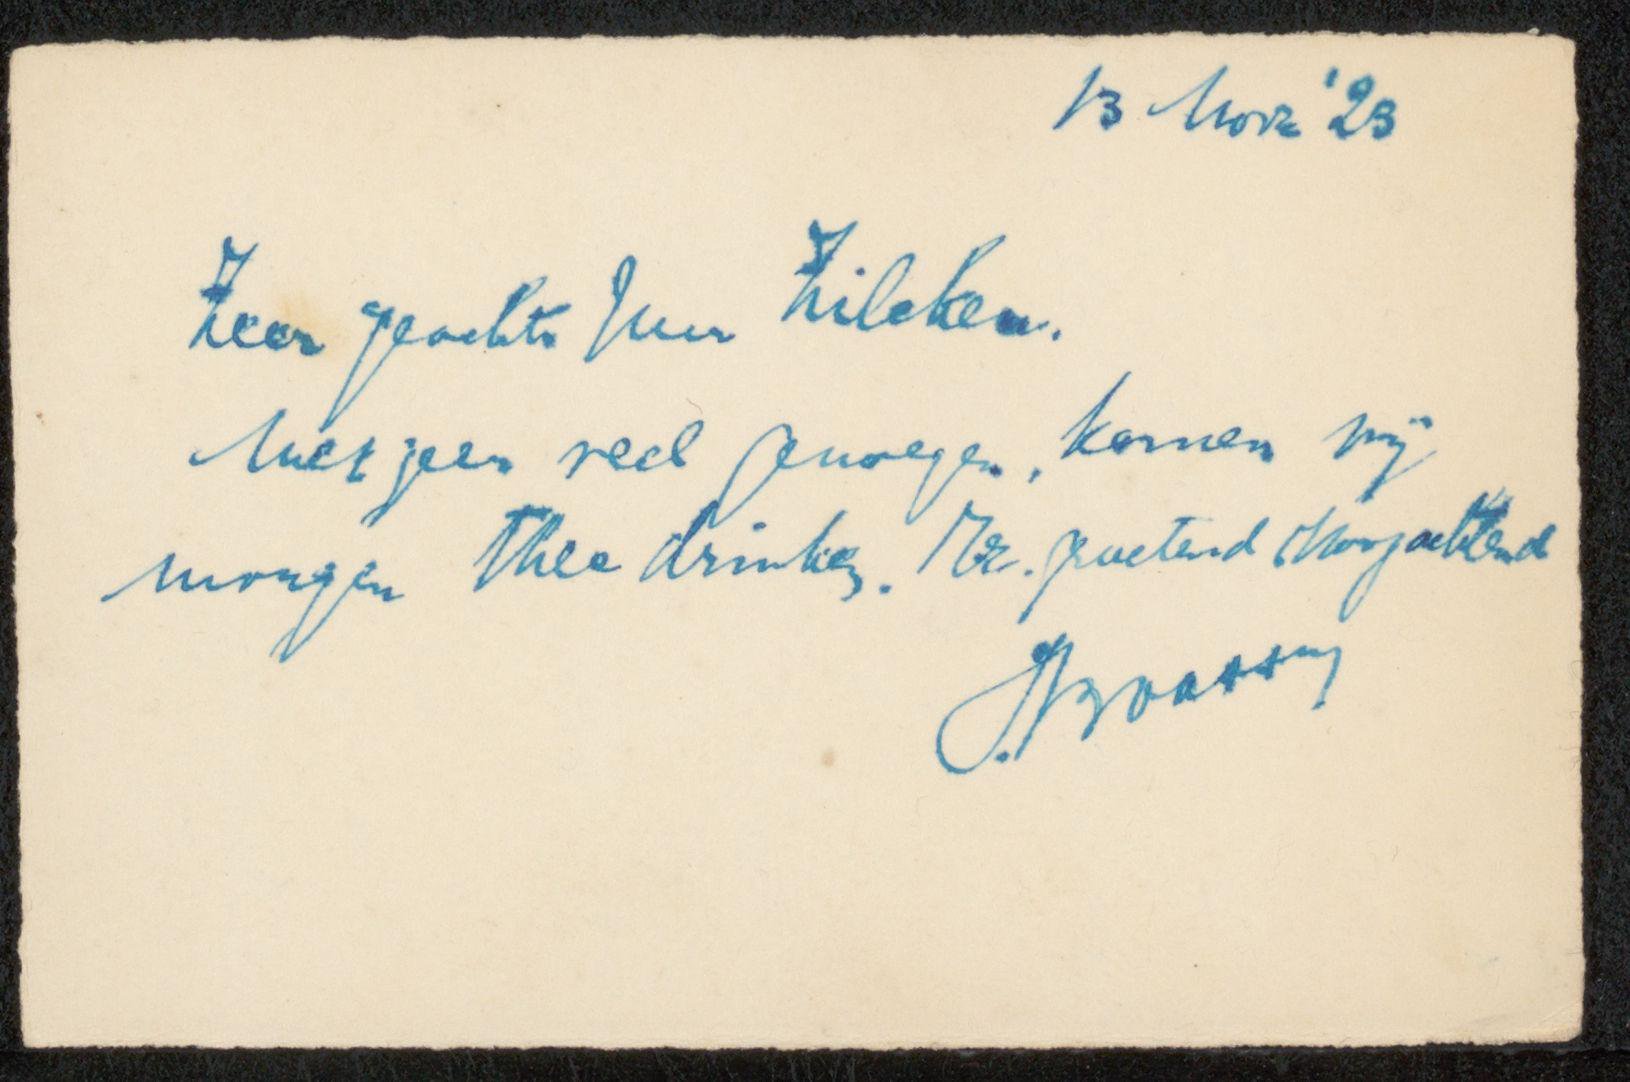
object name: letter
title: Brief aan Philip Zilcken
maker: selma boasson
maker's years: 1884-1924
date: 1923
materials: cardboard, ink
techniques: pen, writing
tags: the hague, painter, draughtsman, philip zilcken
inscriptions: collector's mark: ‘RPK’